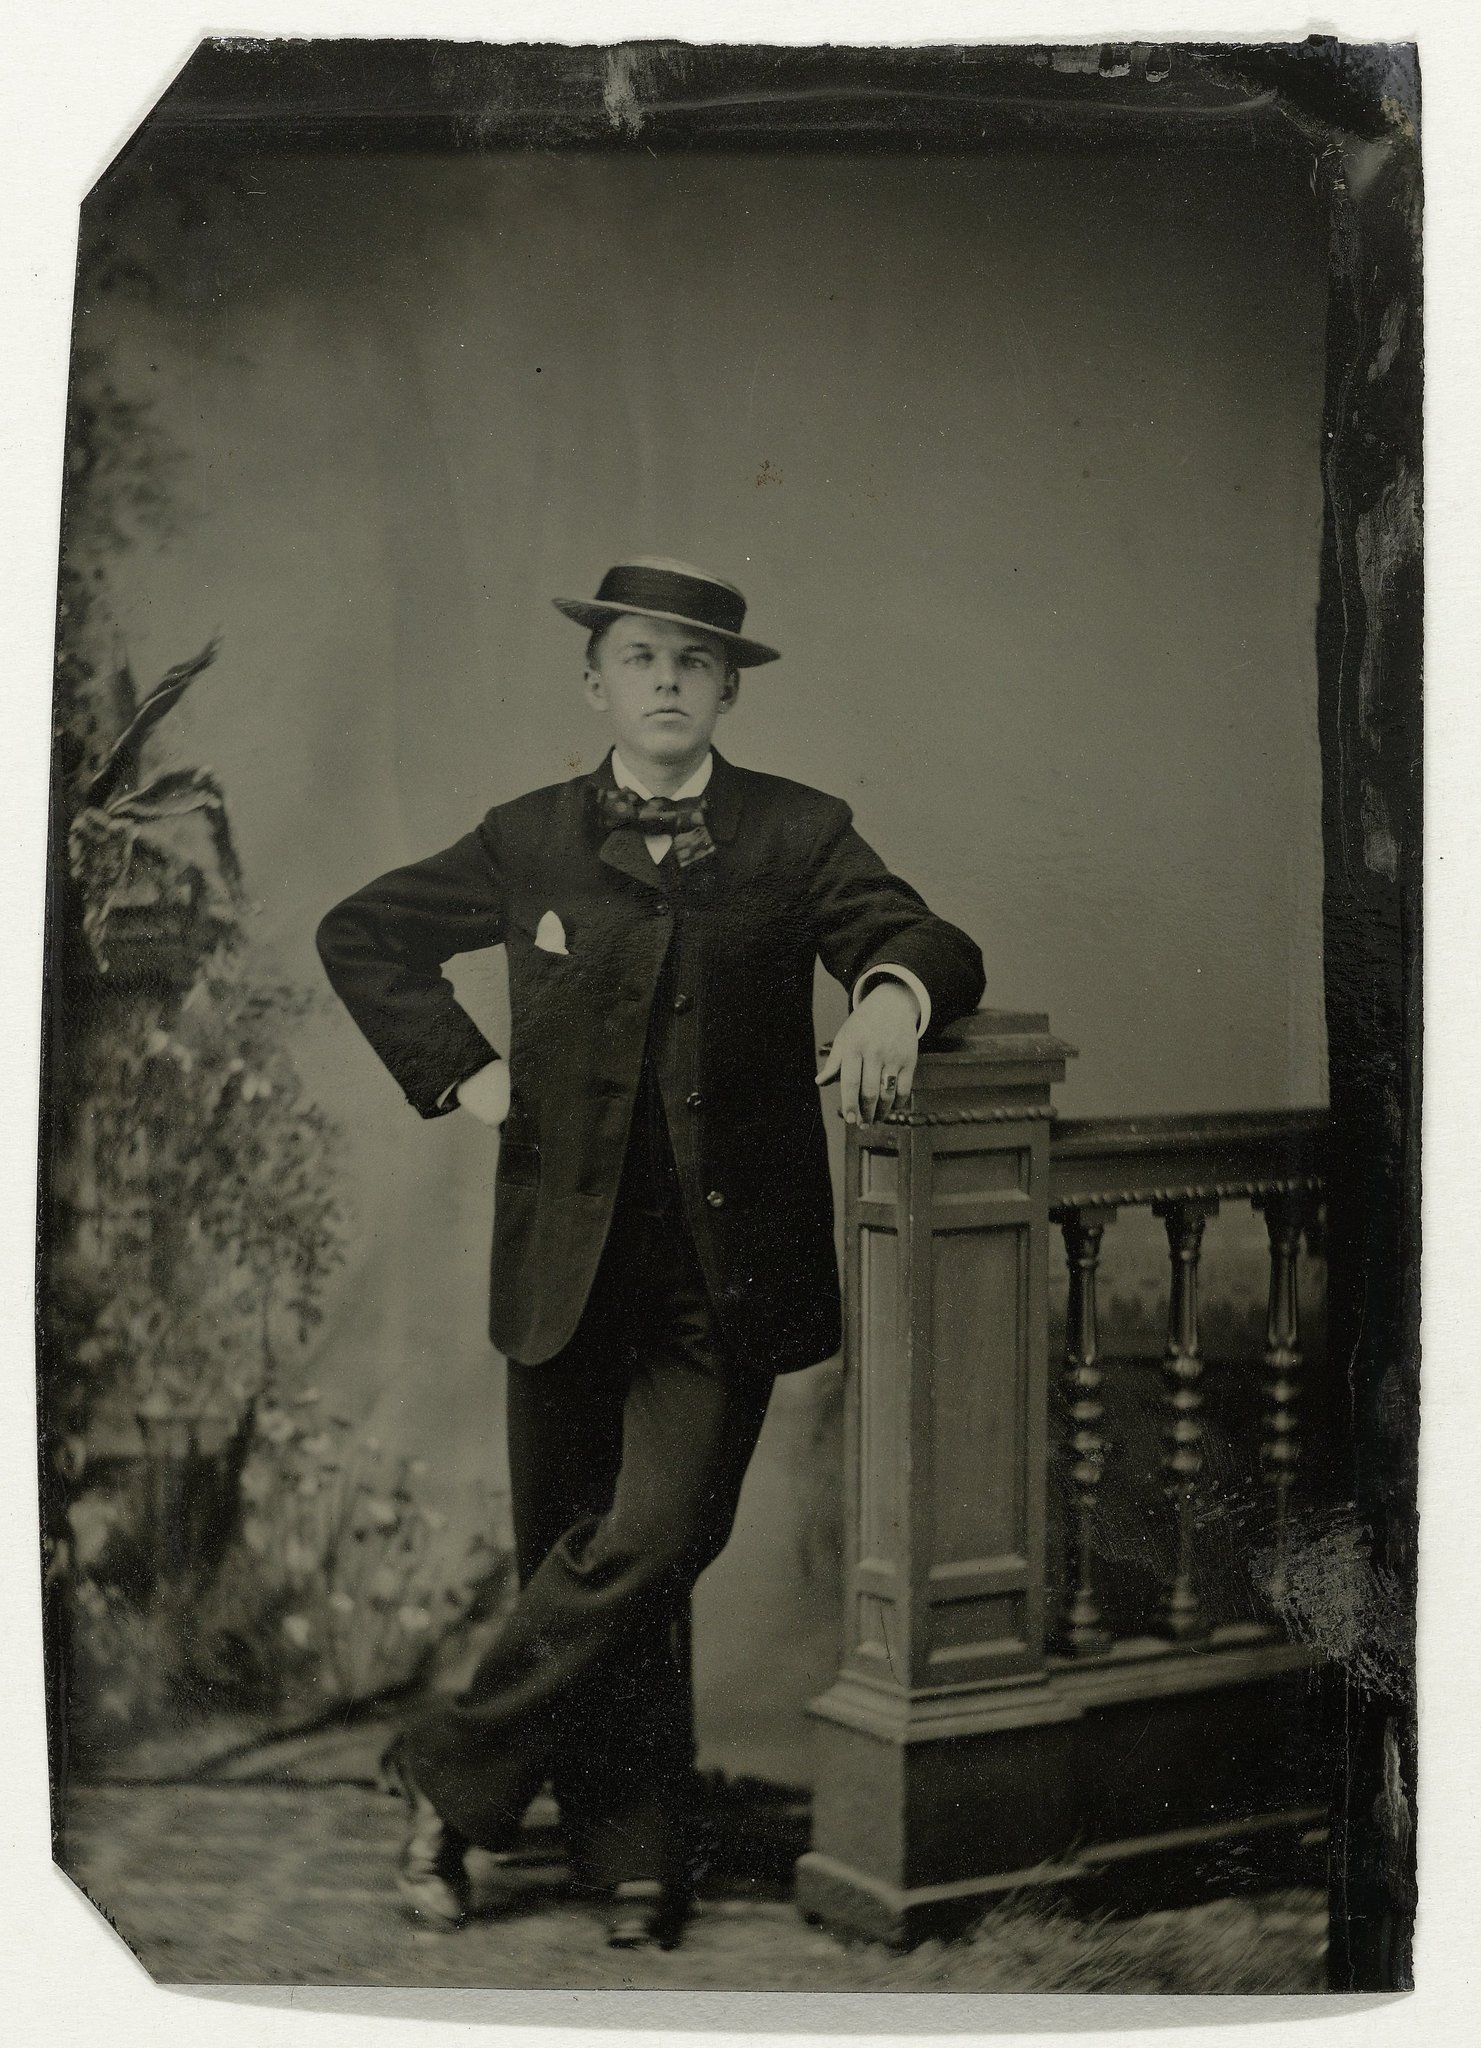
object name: photograph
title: Portret van een jongeman, staand bij een balustrade voor een geschilderd achtergronddoek.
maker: Anonymous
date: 1860-1900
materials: metal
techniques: ferrotyping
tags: anonymous historical person portrayed